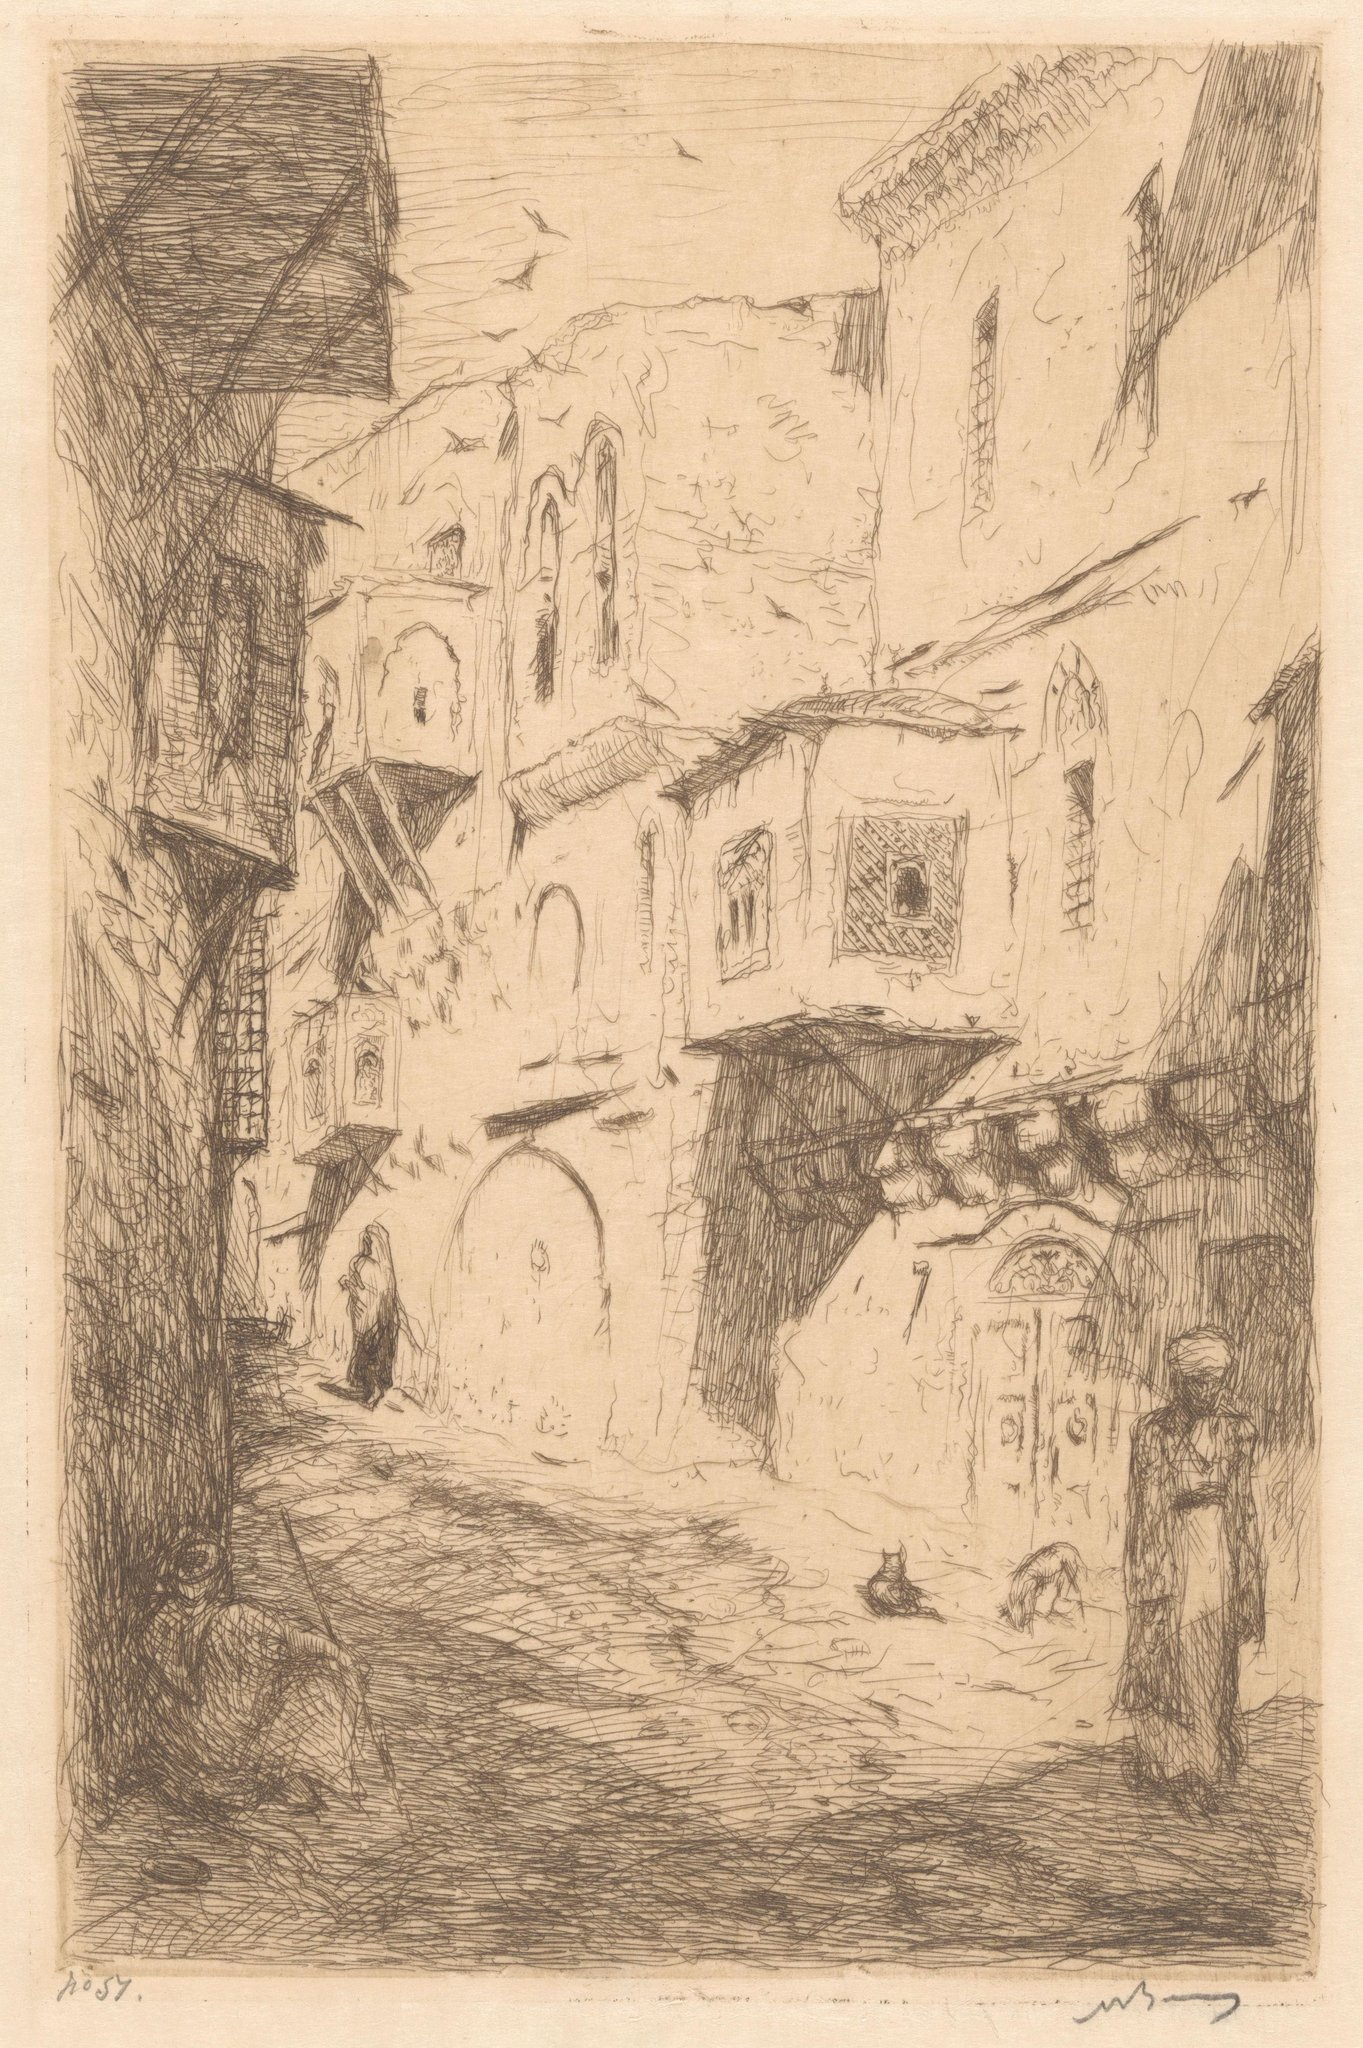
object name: print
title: Straat in India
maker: marius bauer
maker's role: draughtsman, print maker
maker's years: 1867-1932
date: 1926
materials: paper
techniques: etching, intaglio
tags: sloping street; street with steps or stairs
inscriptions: collector's mark: Lugt 2228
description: Een hellende straat met aan weerszijden huizen. Op straat drie figuren, waarvan twee wandelend en één zittend, en daarnaast twee honden.